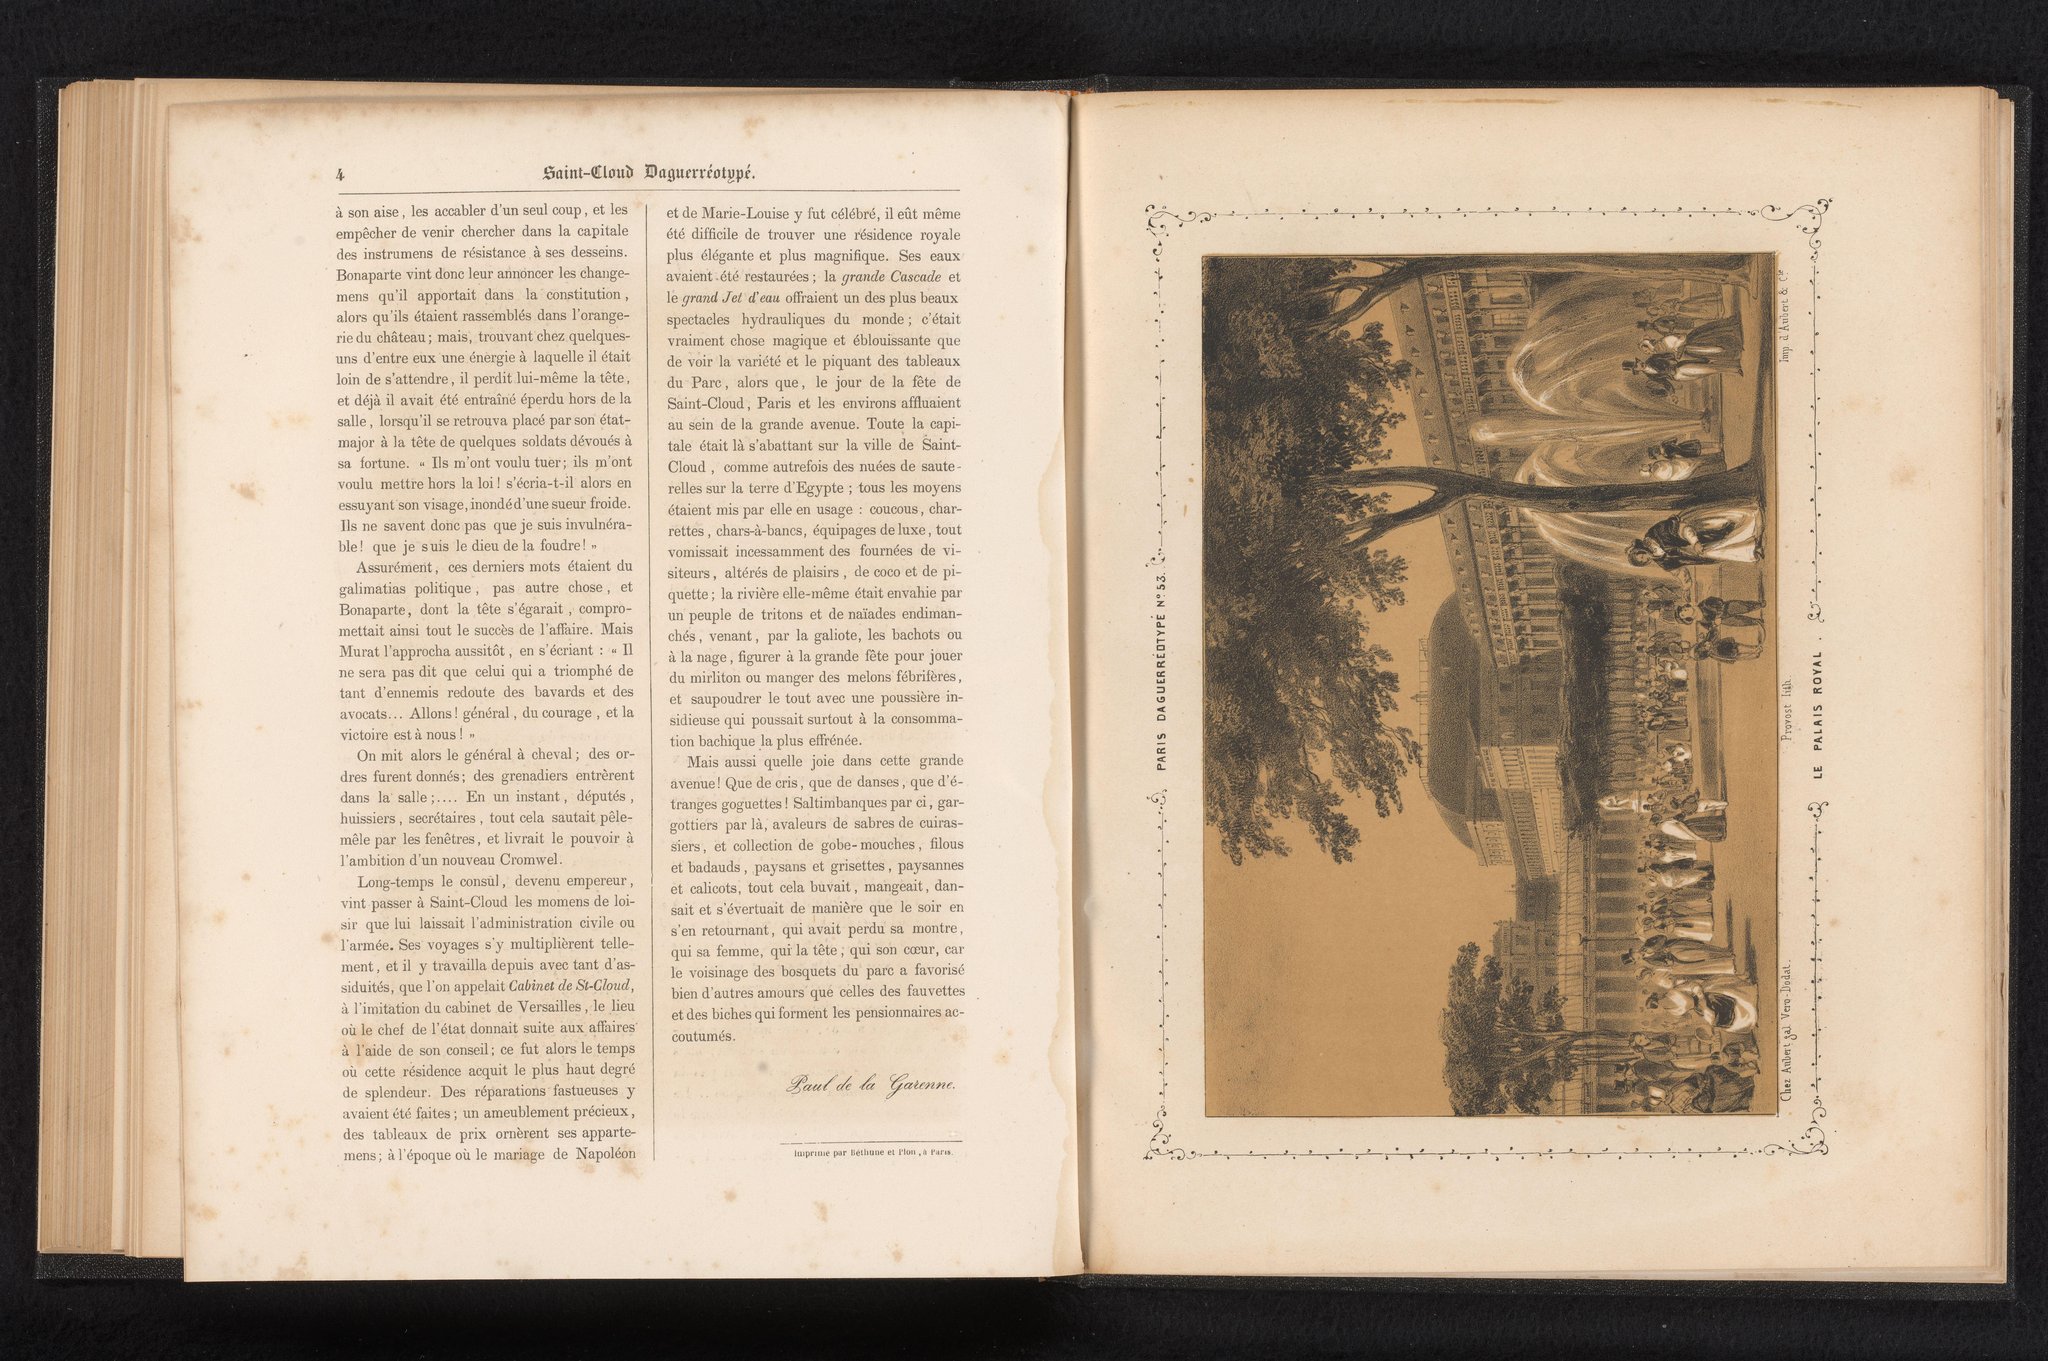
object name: page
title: Le Palais Royal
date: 1839-1840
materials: paper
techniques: tone lithography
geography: paris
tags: palace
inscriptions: inscription: ‘PARIS DAGUERRÉOTYPÉ No. 53.’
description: Prent op tweehonderdenelfde ongenummerde pagina.